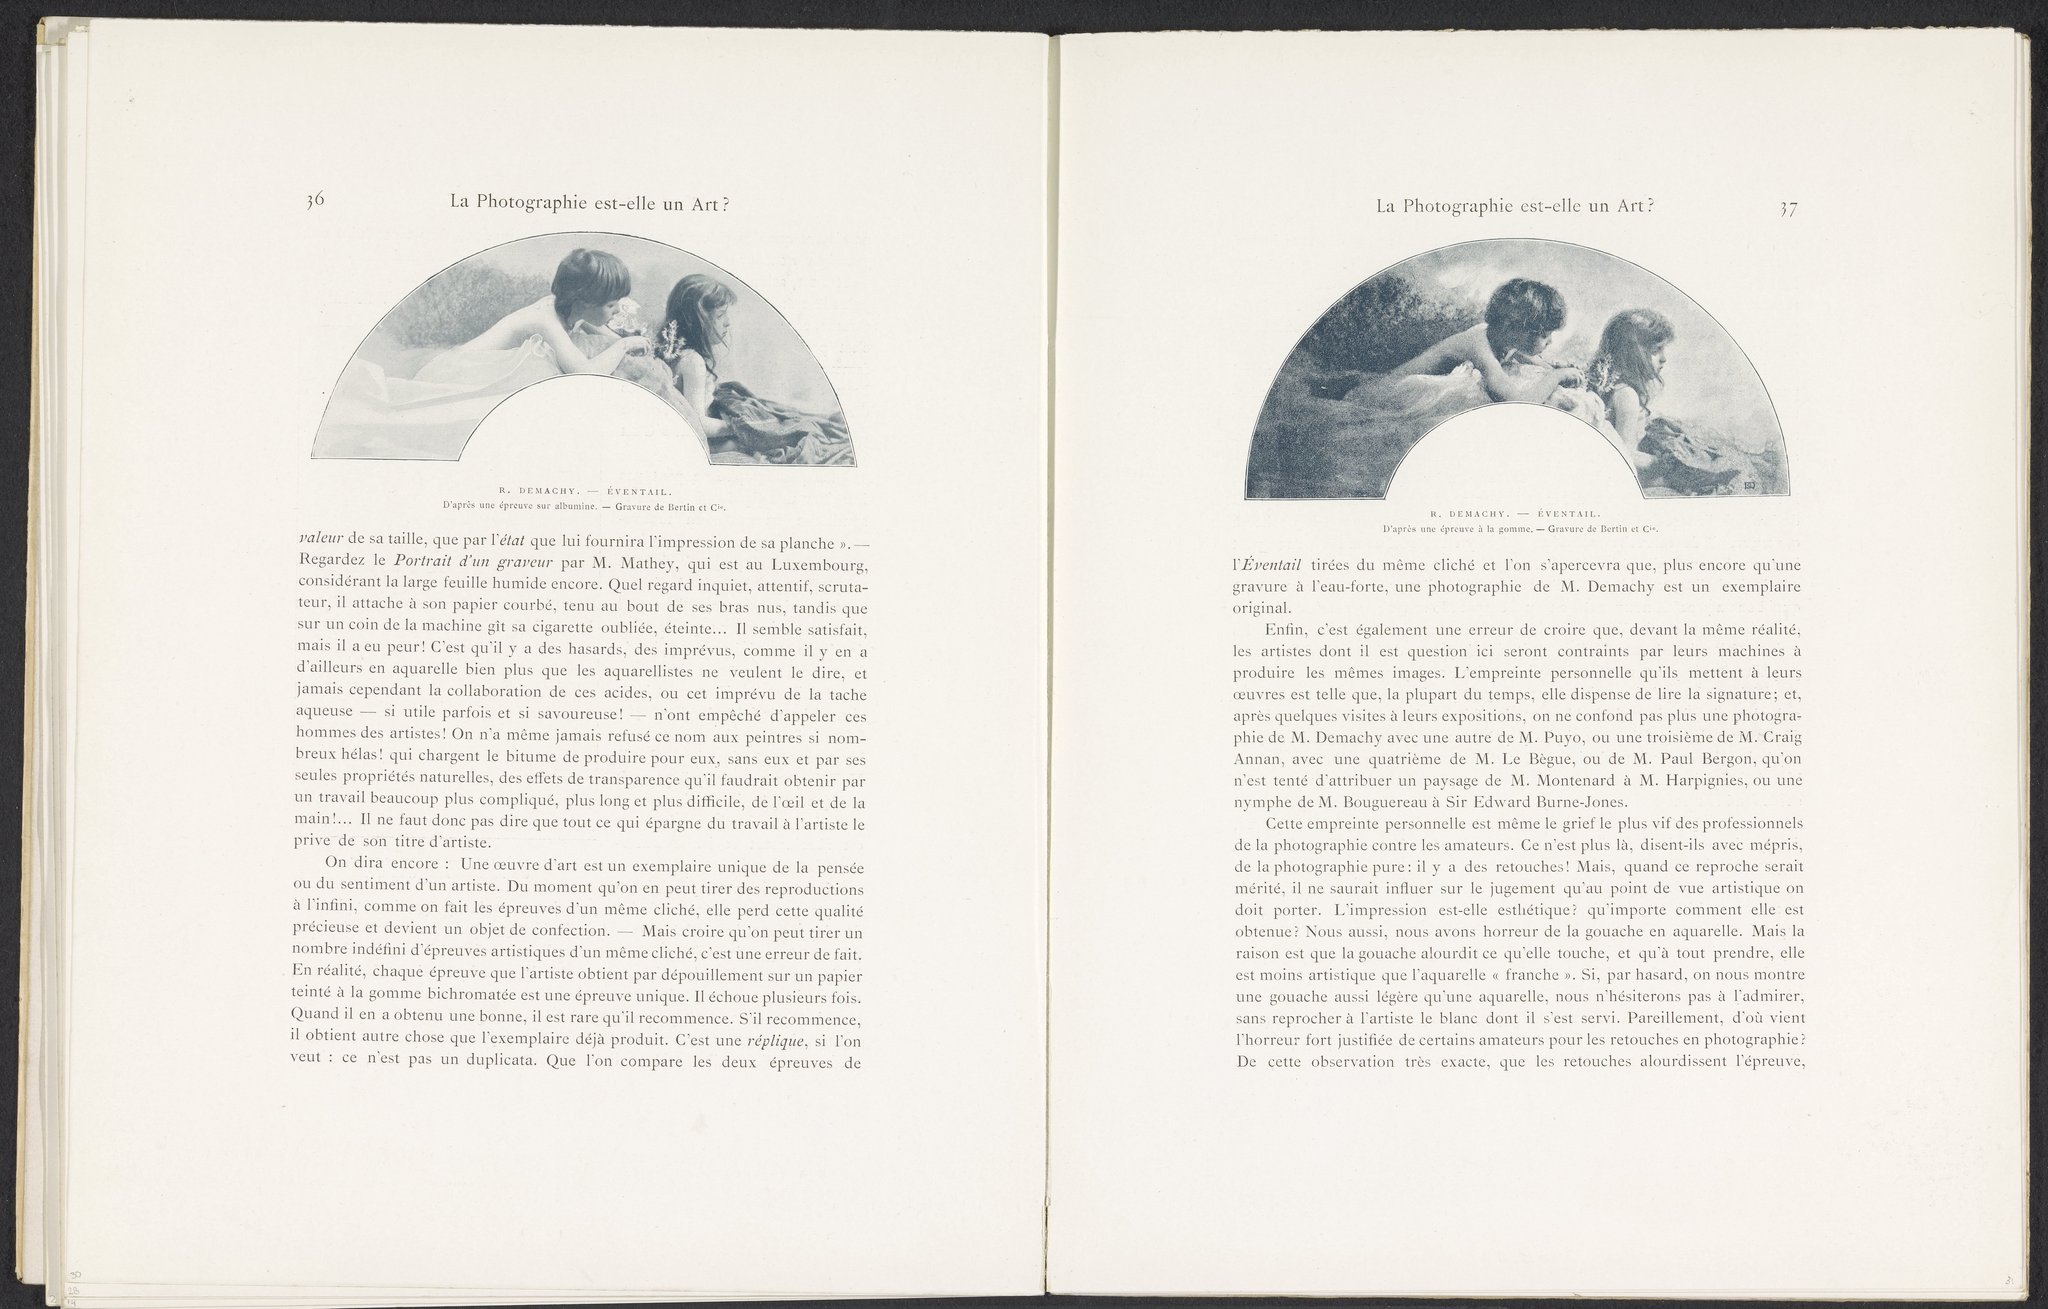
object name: photomechanical print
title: Éventail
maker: robert demachy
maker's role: fotograaf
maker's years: 1859-1936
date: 1889-1899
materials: paper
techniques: autotype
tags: boy (child between toddler and youth), girl (child between toddler and youth)